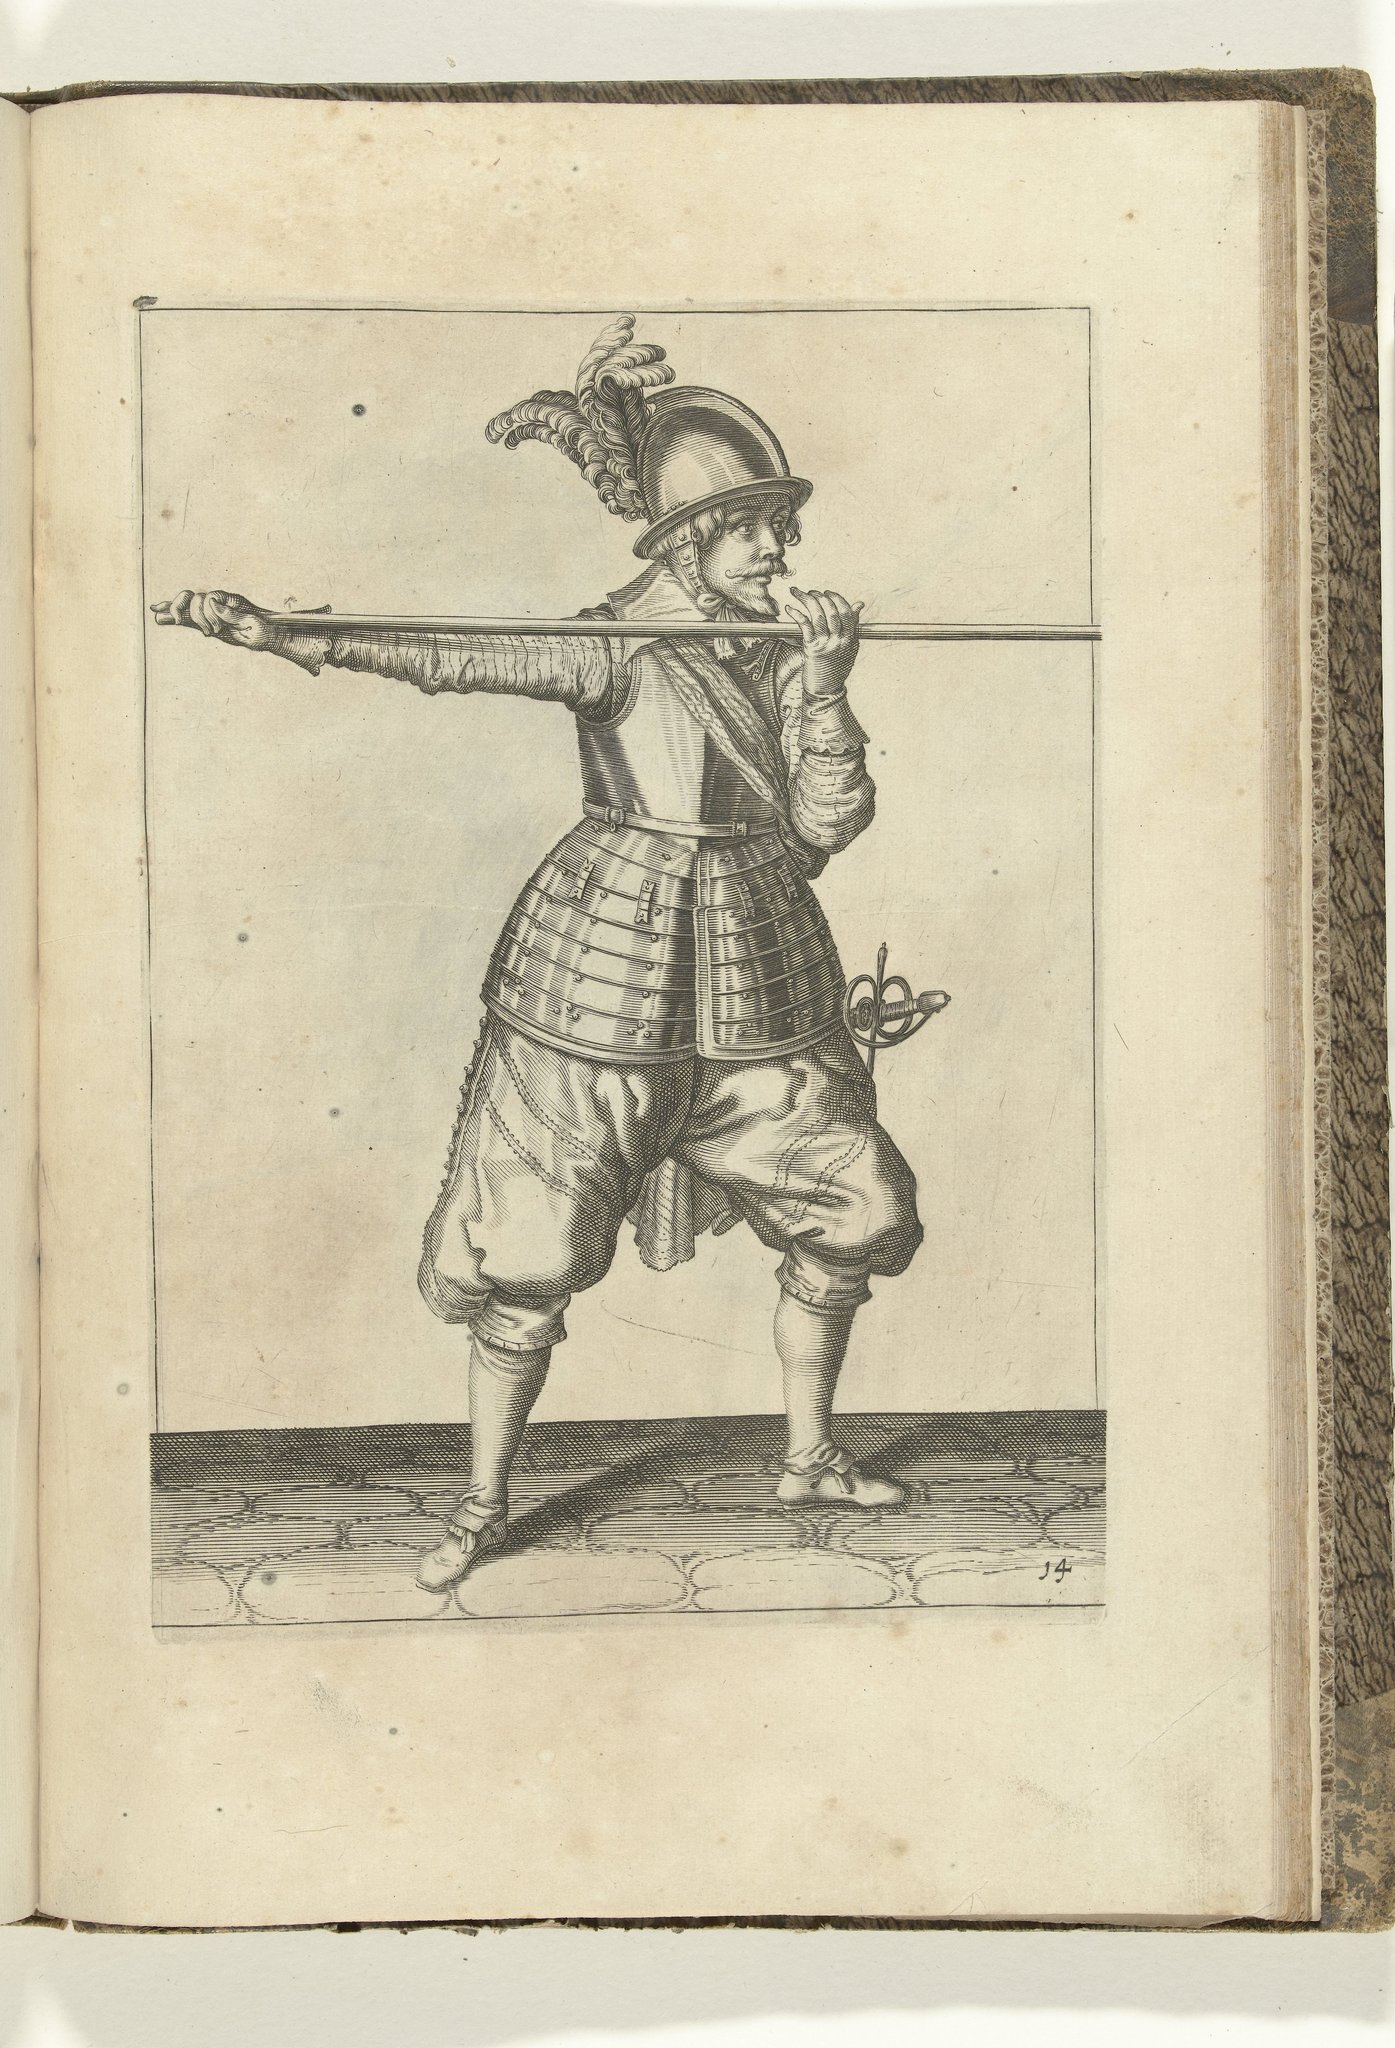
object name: print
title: Soldaat die zijn spies met beide handen horizontaal op schouderhoogte draagt, zijn rechterhand bij de voet van het wapen (nr. 14), ca. 1600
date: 1597-1608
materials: paper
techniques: engraving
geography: amsterdam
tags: the hague, maurice (prince of orange), handling of weapons ~ military training, weapons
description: Een soldaat, ten voeten uit, die een spies (lans) met beide handen horizontaal op schouderhoogte draagt, zijn rechterhand bij de voet van het wapen (nr. 14), ca. 1600. Dit is de derde handeling voor het laten zakken van de spies om onder een overwelving door te kunnen. Plaat 14 in de instructies voor het hanteren van de spies: Enseignement brief; et succint sur les portraitz figurez, touchant l'usage, de tout ce qu'un Soldat doibt faire au maniement de la Pique. Onderdeel van de illustraties in een Franse editie van J. de Gheyns Wapenhandelinghe: J. de Gheyn, Maniement d'armes, d'arquebuses, mousquetz et piques : en conformité de l'ordre de Mour le Prince Maurice, Prince d'Orange, Amsterdam 1608. Krijgswezen rond 1600.